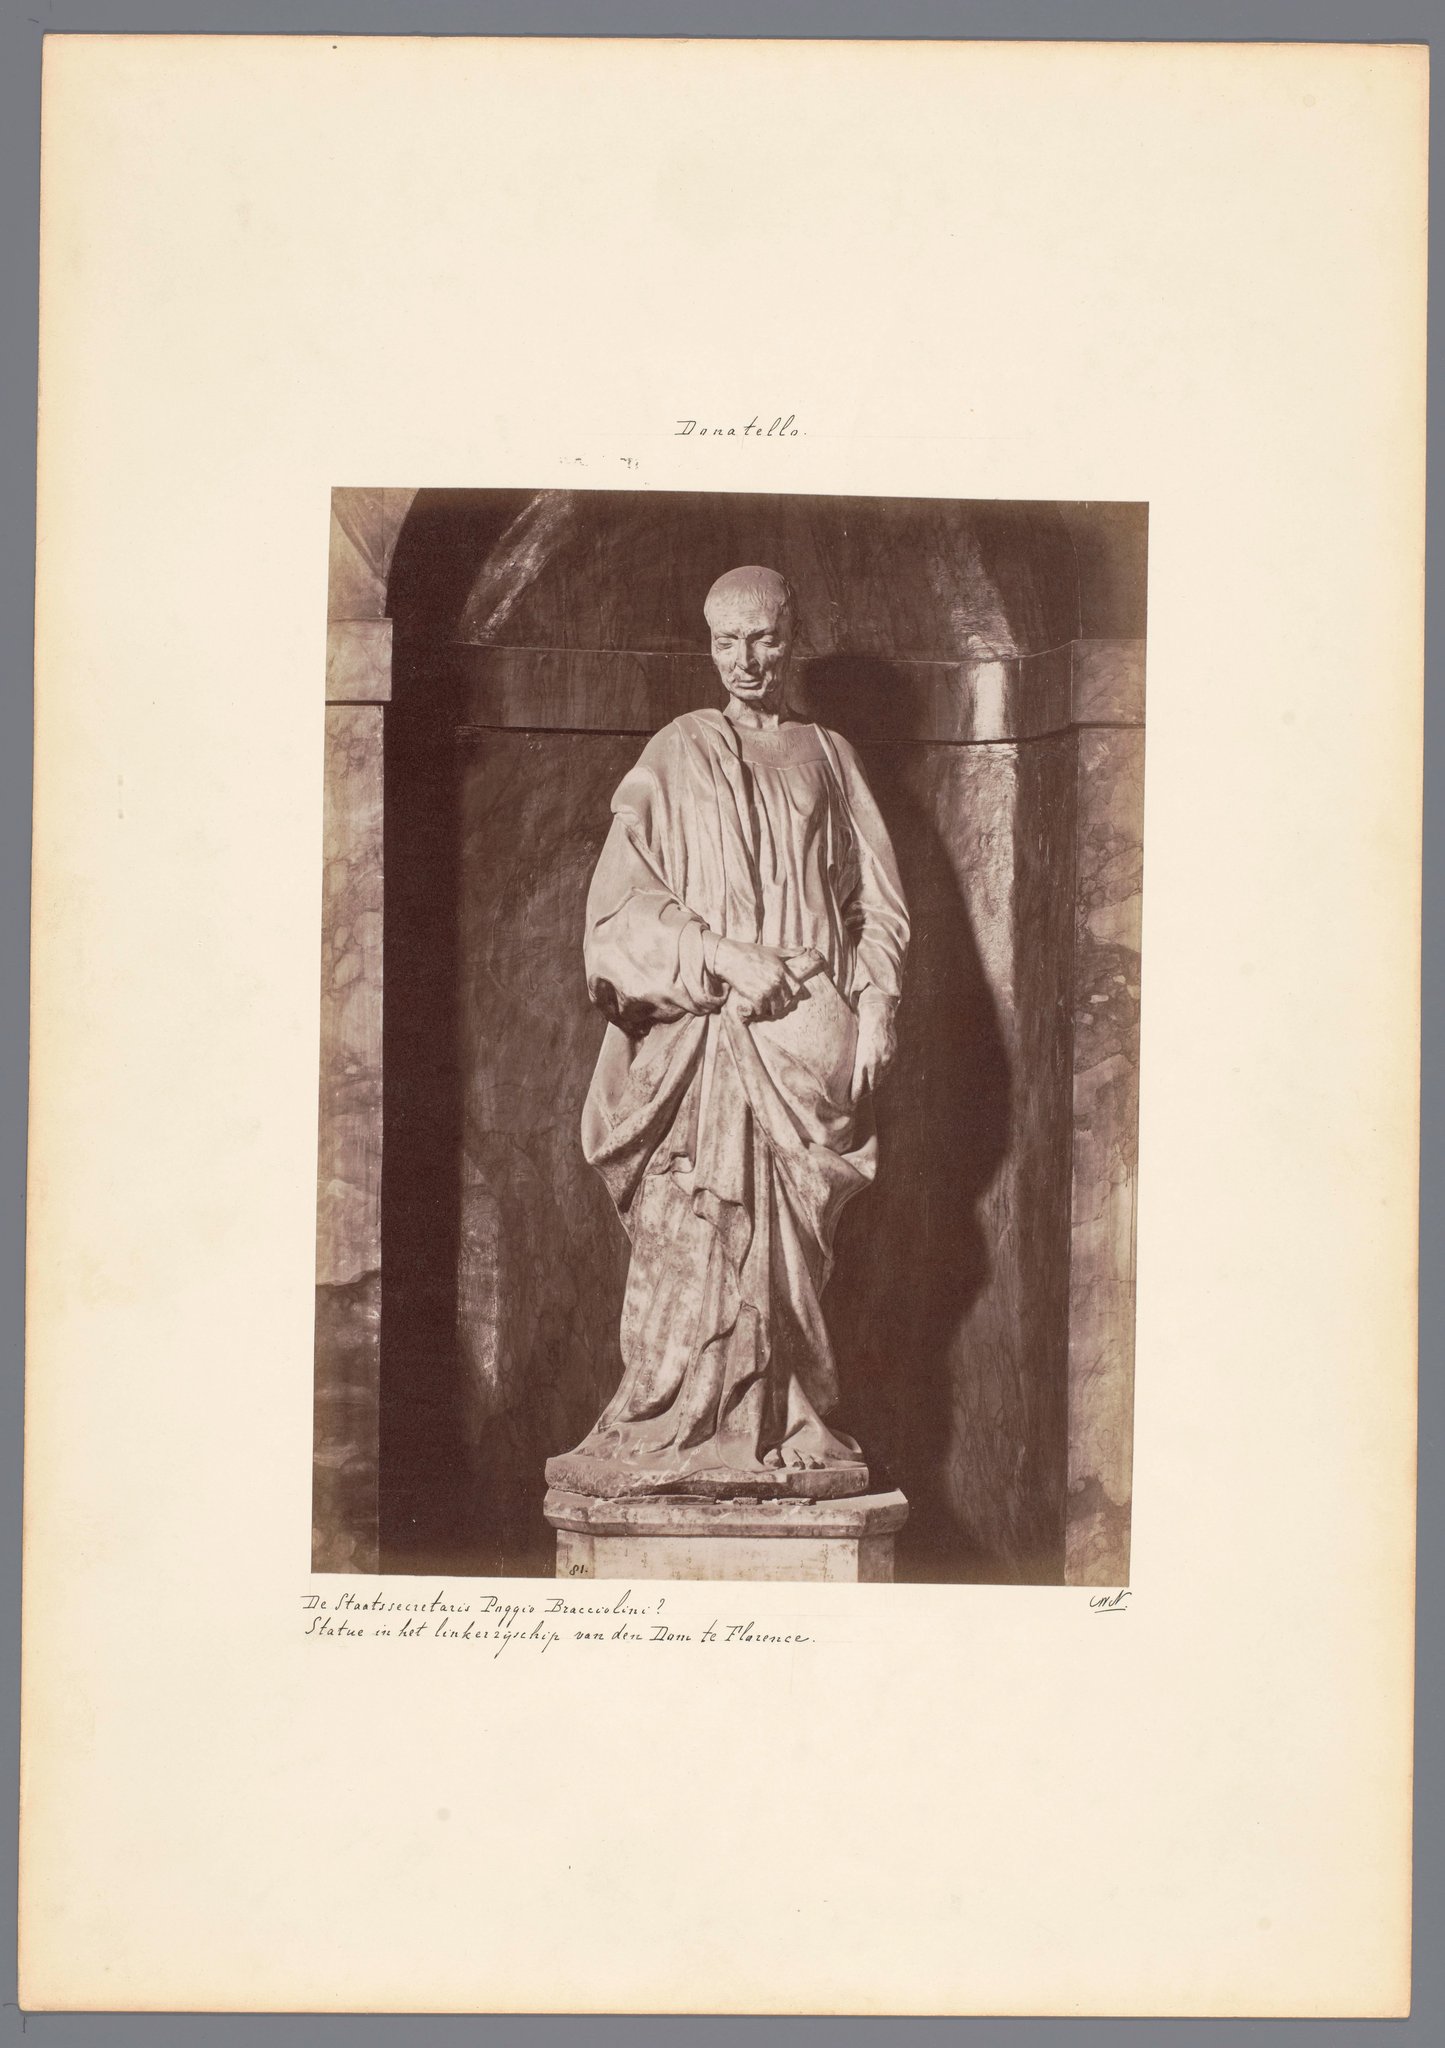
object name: photograph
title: Donatello. De Staatssecretaris Poggio Bracciolini? Statue in het linkerzijschip van den Dom te Florence.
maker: Anonymous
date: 1875-1900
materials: cardboard, photographic support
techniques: albumen print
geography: florence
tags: monument, statue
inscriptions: inscription: ‘CWN.’, number: ‘81.’, collector's mark: ‘KUNSTNIJVERHEIDSCHOOL QUELLINUS AMSTERDAM FRANS HALSSTRAAT 14.’